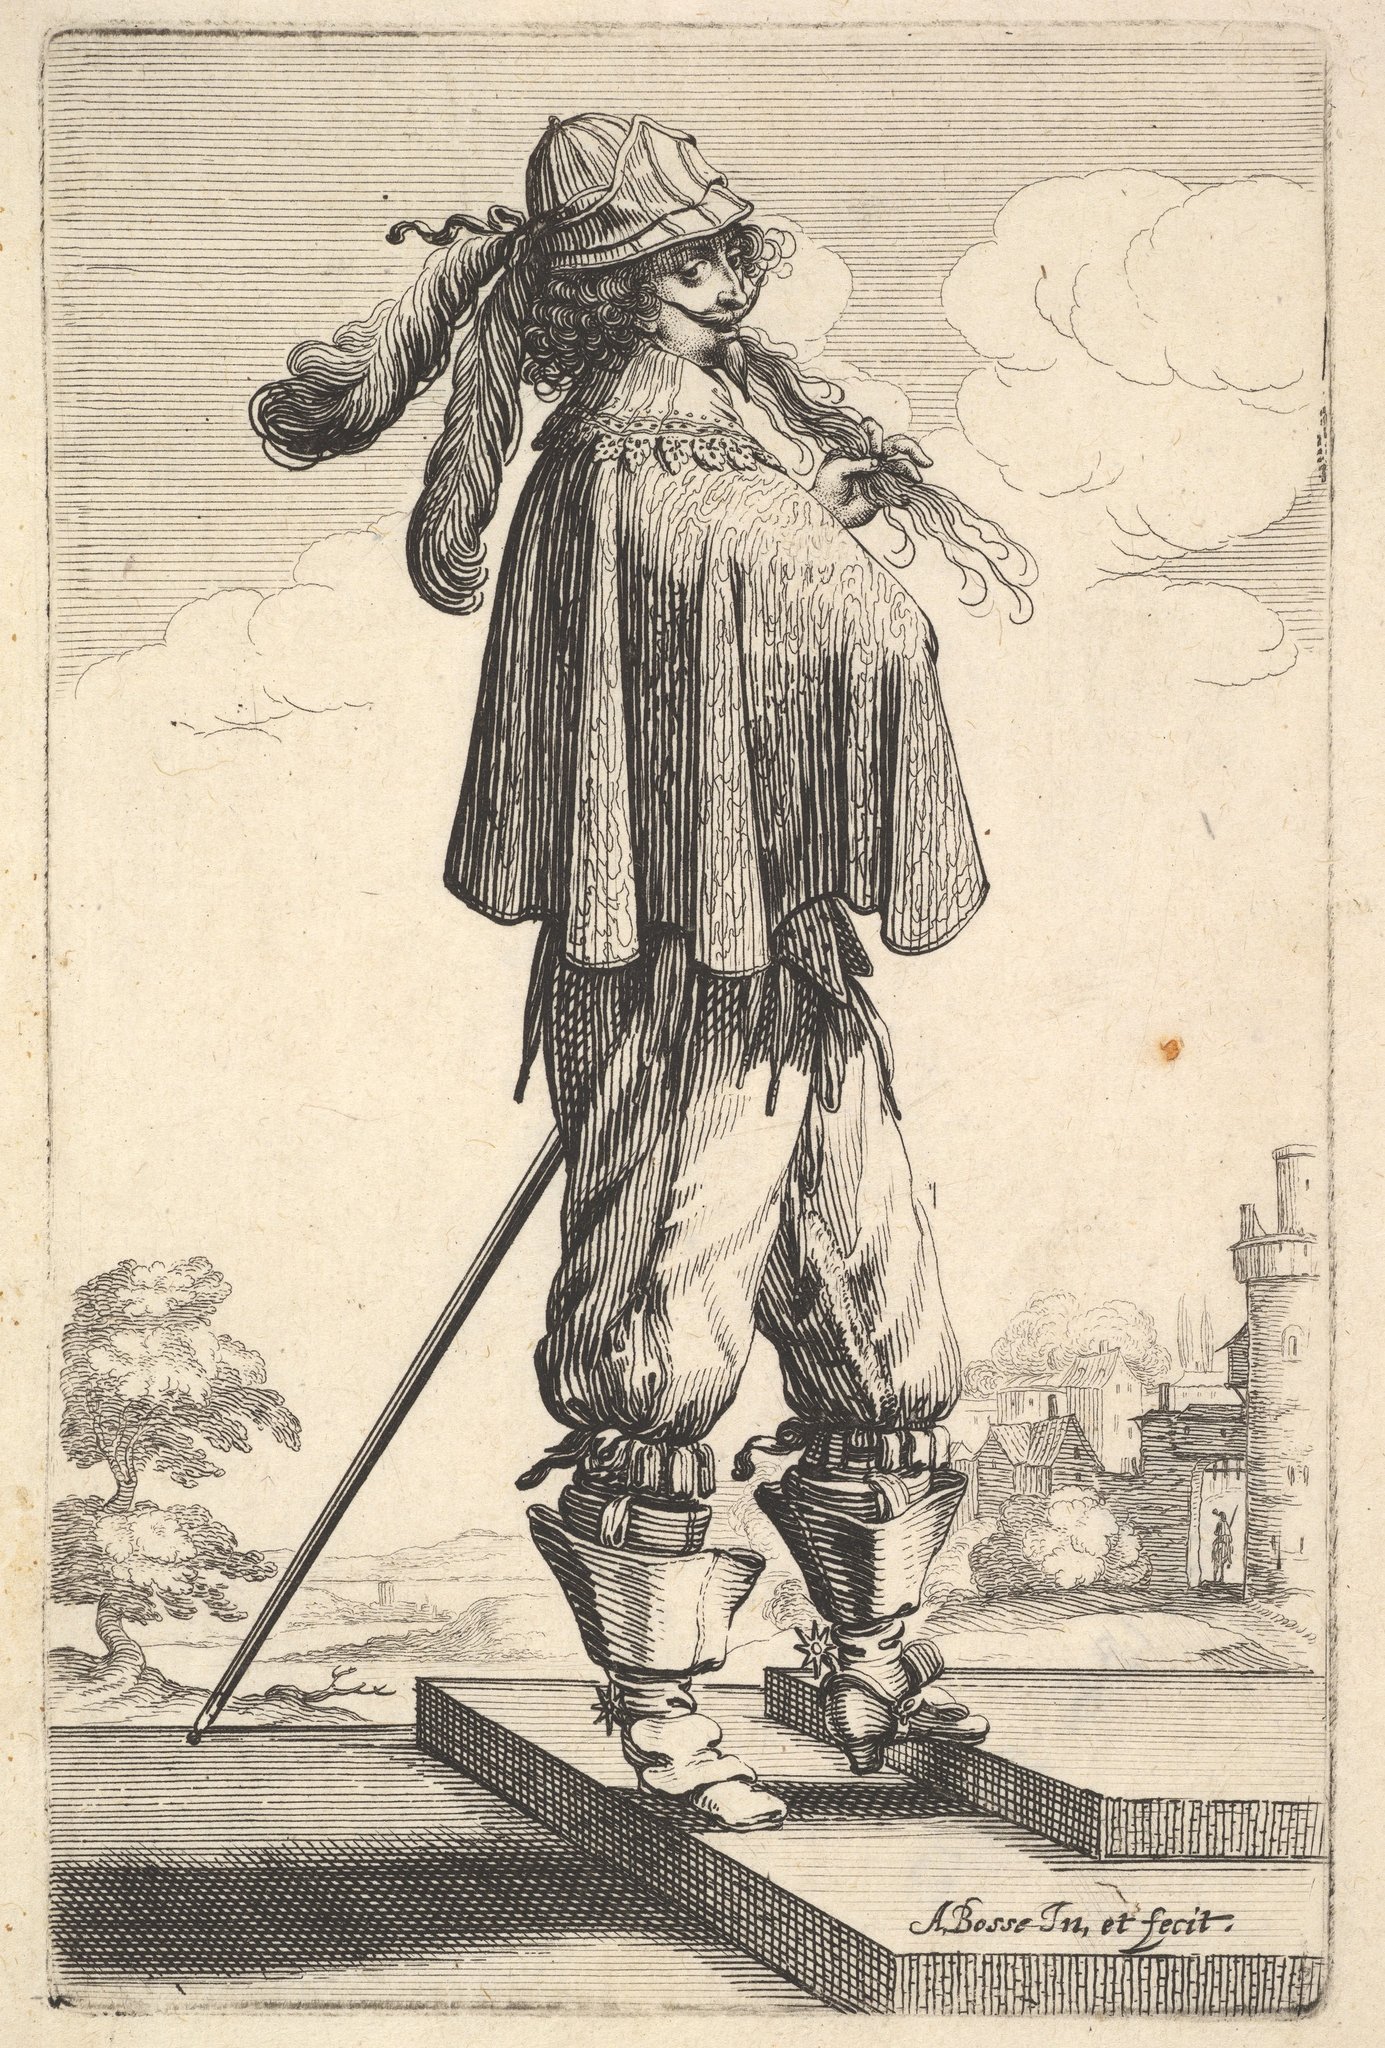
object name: print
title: A gentleman wearing a short coat, a helmet, and boots with spurs, standing on the steps and turned towards the right, from "The Garden of the French Nobles In Which One Can Pick Up Their Way of Dressing"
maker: abraham bosse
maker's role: artist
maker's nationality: french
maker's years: 1602-1676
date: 1629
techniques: etching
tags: men